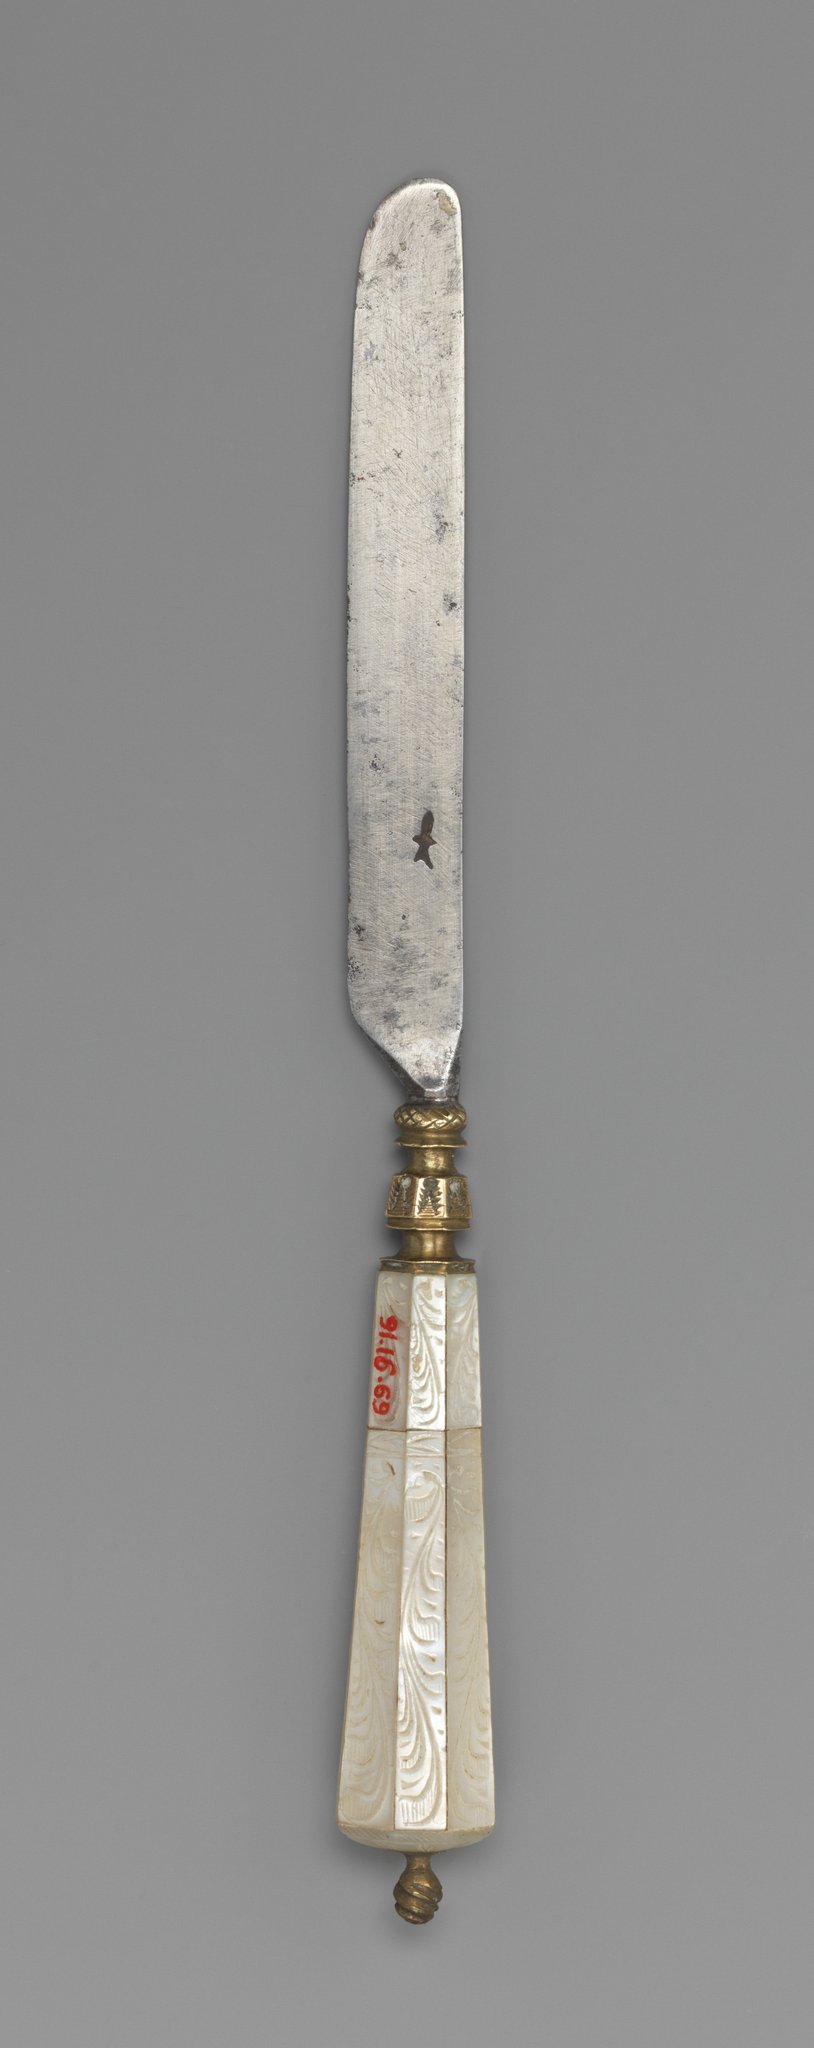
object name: fruit knife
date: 1690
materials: brass, bronze, mother of pearl, steel, wood